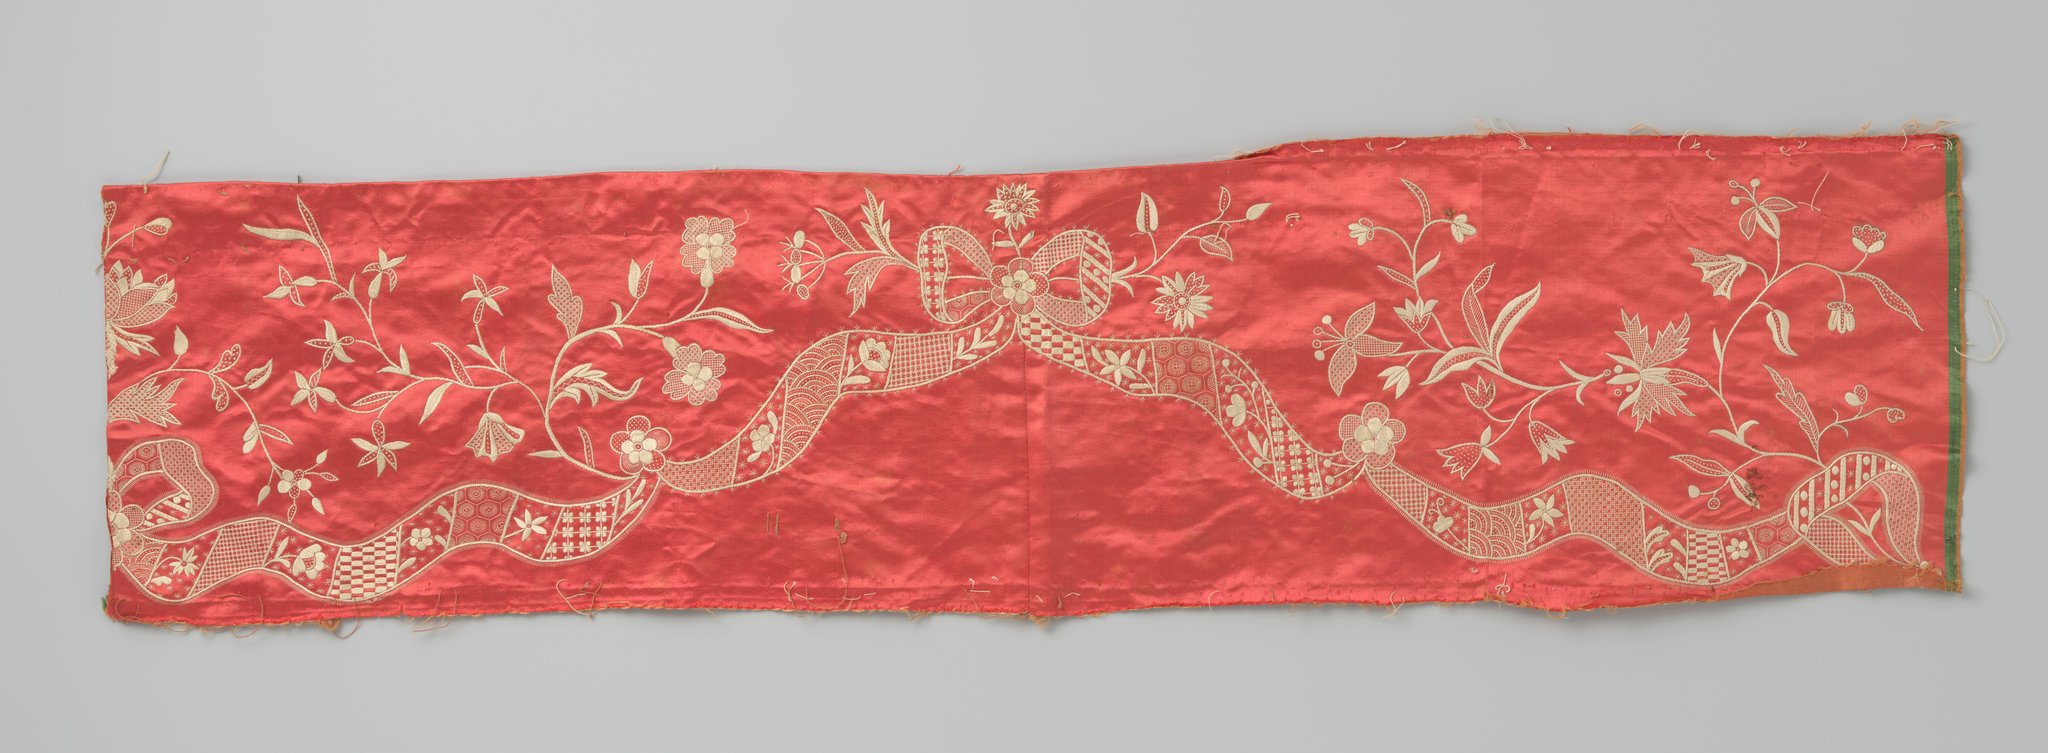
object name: strip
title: Embroidered Interior Textile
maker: Anonymous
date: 1750-1760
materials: silk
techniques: embroidered, weave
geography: france